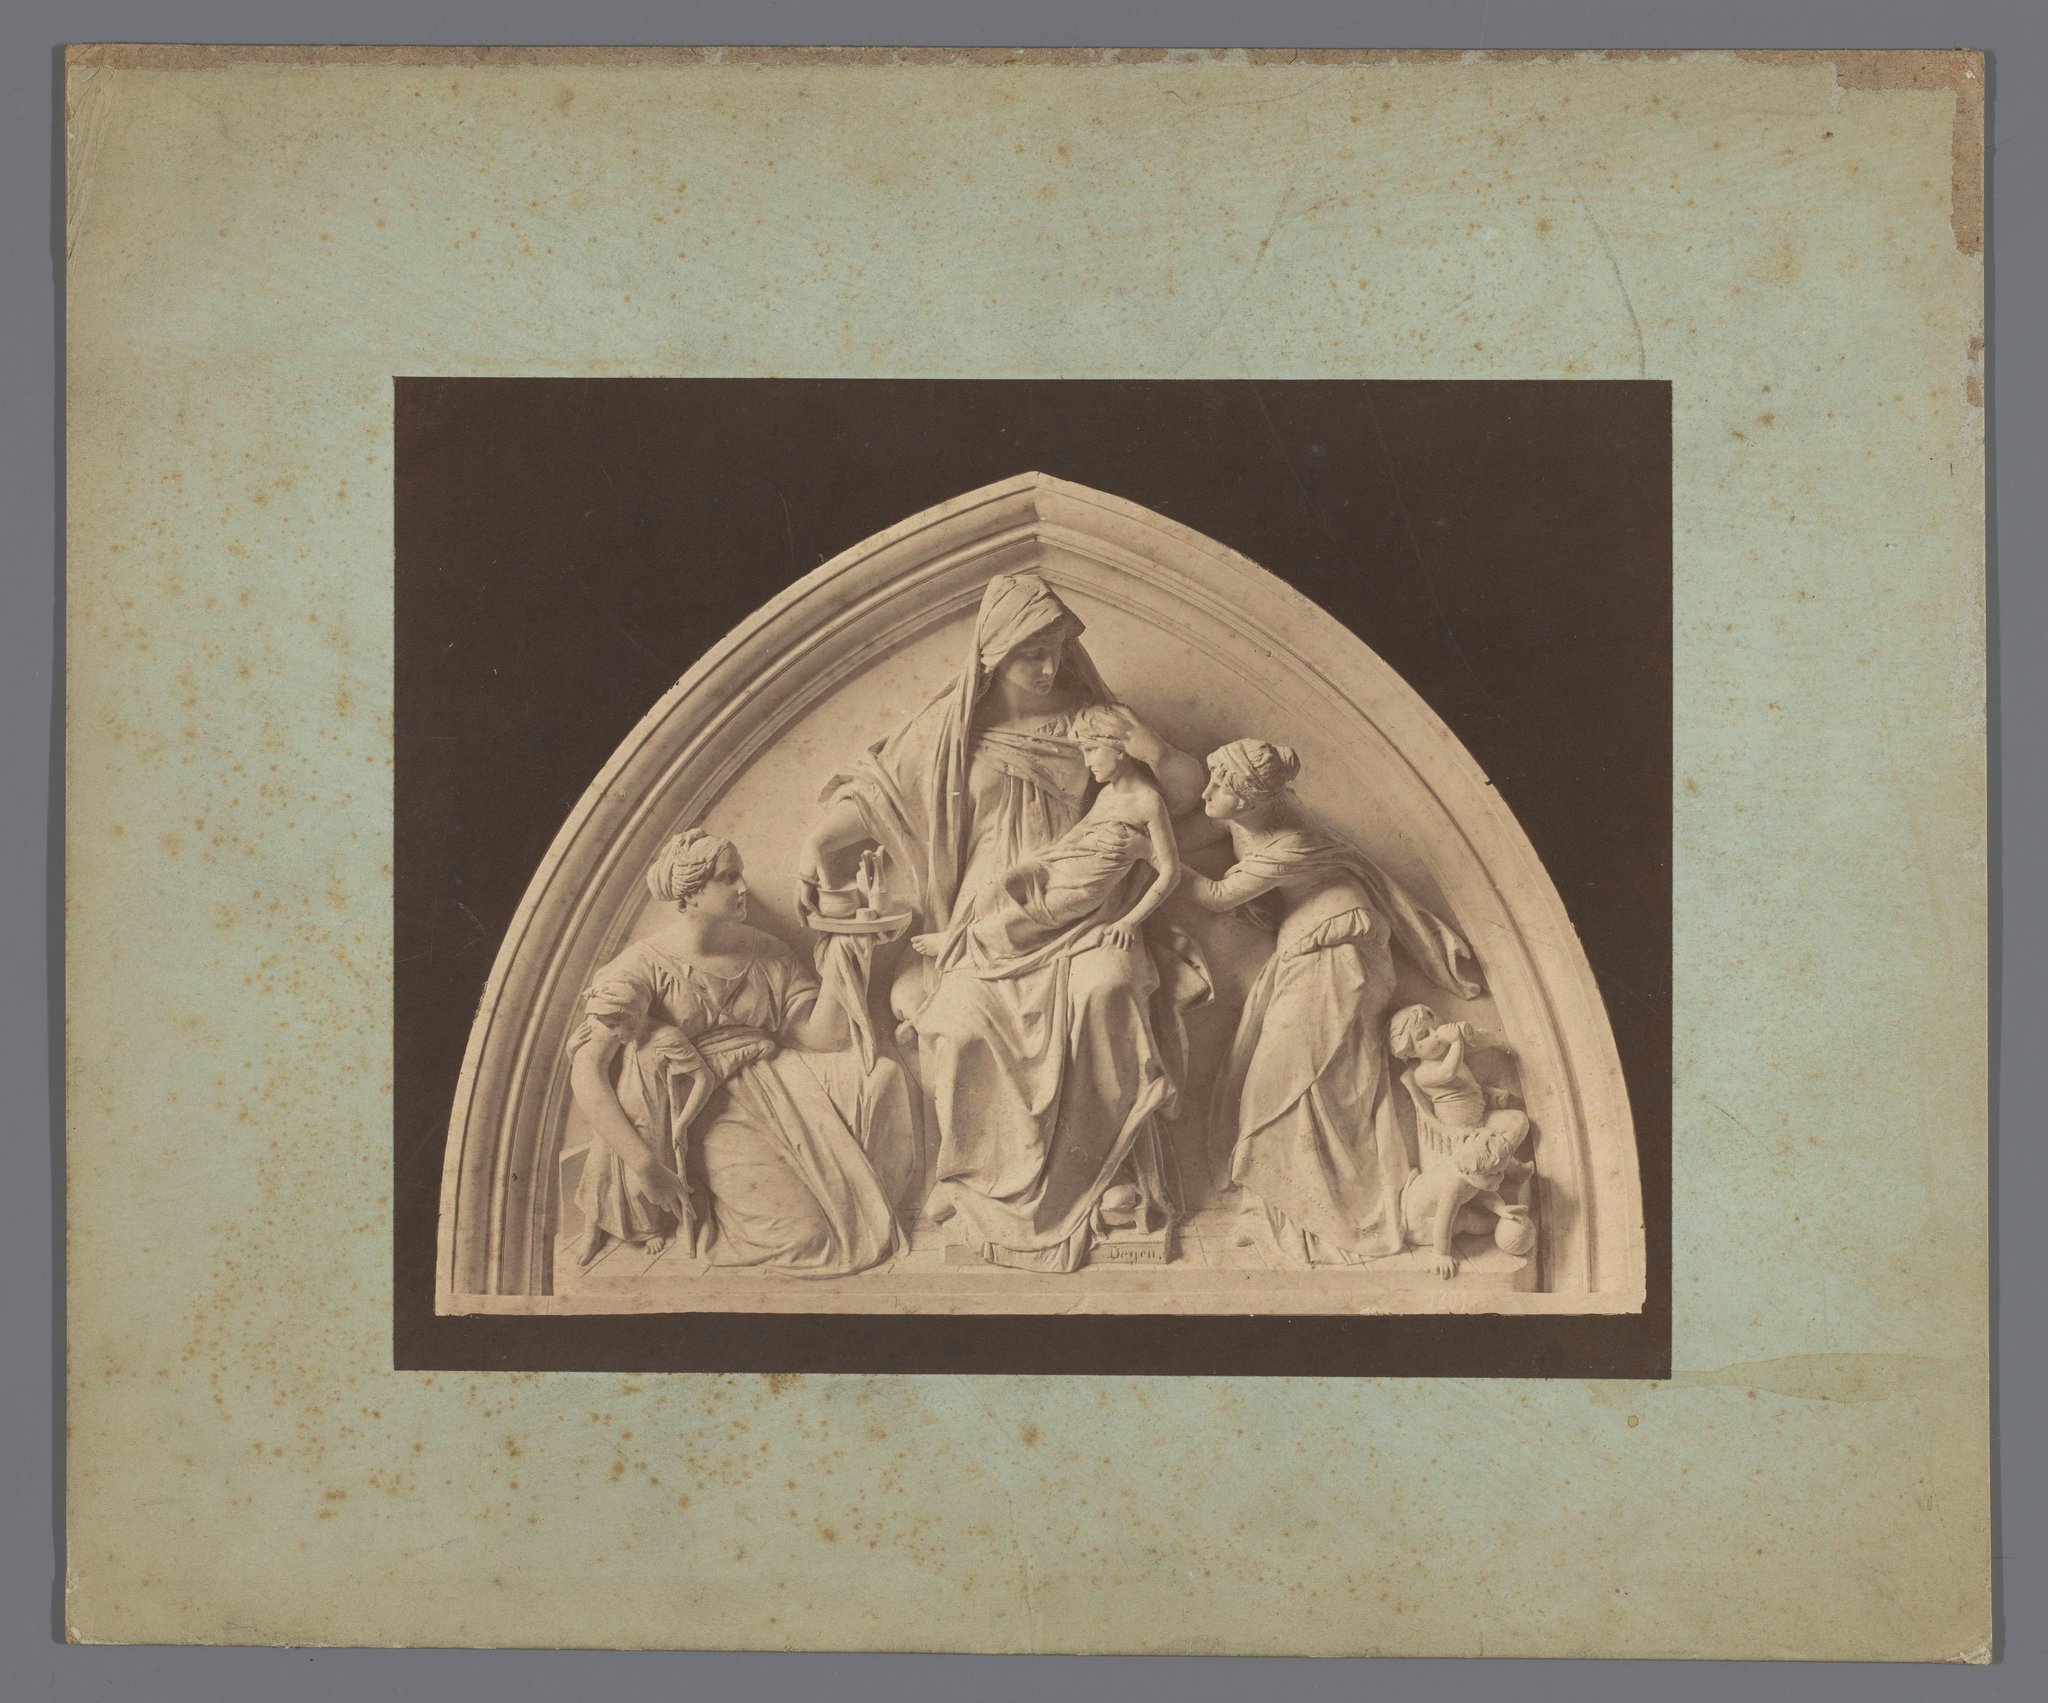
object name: photograph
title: Timpaan waarop de zieken worden verzorgd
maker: Anonymous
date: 1850-1900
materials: cardboard, photographic support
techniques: albumen print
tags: parts of church exterior and annexes: tympanum, patient, sick person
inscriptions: number: ‘1201’